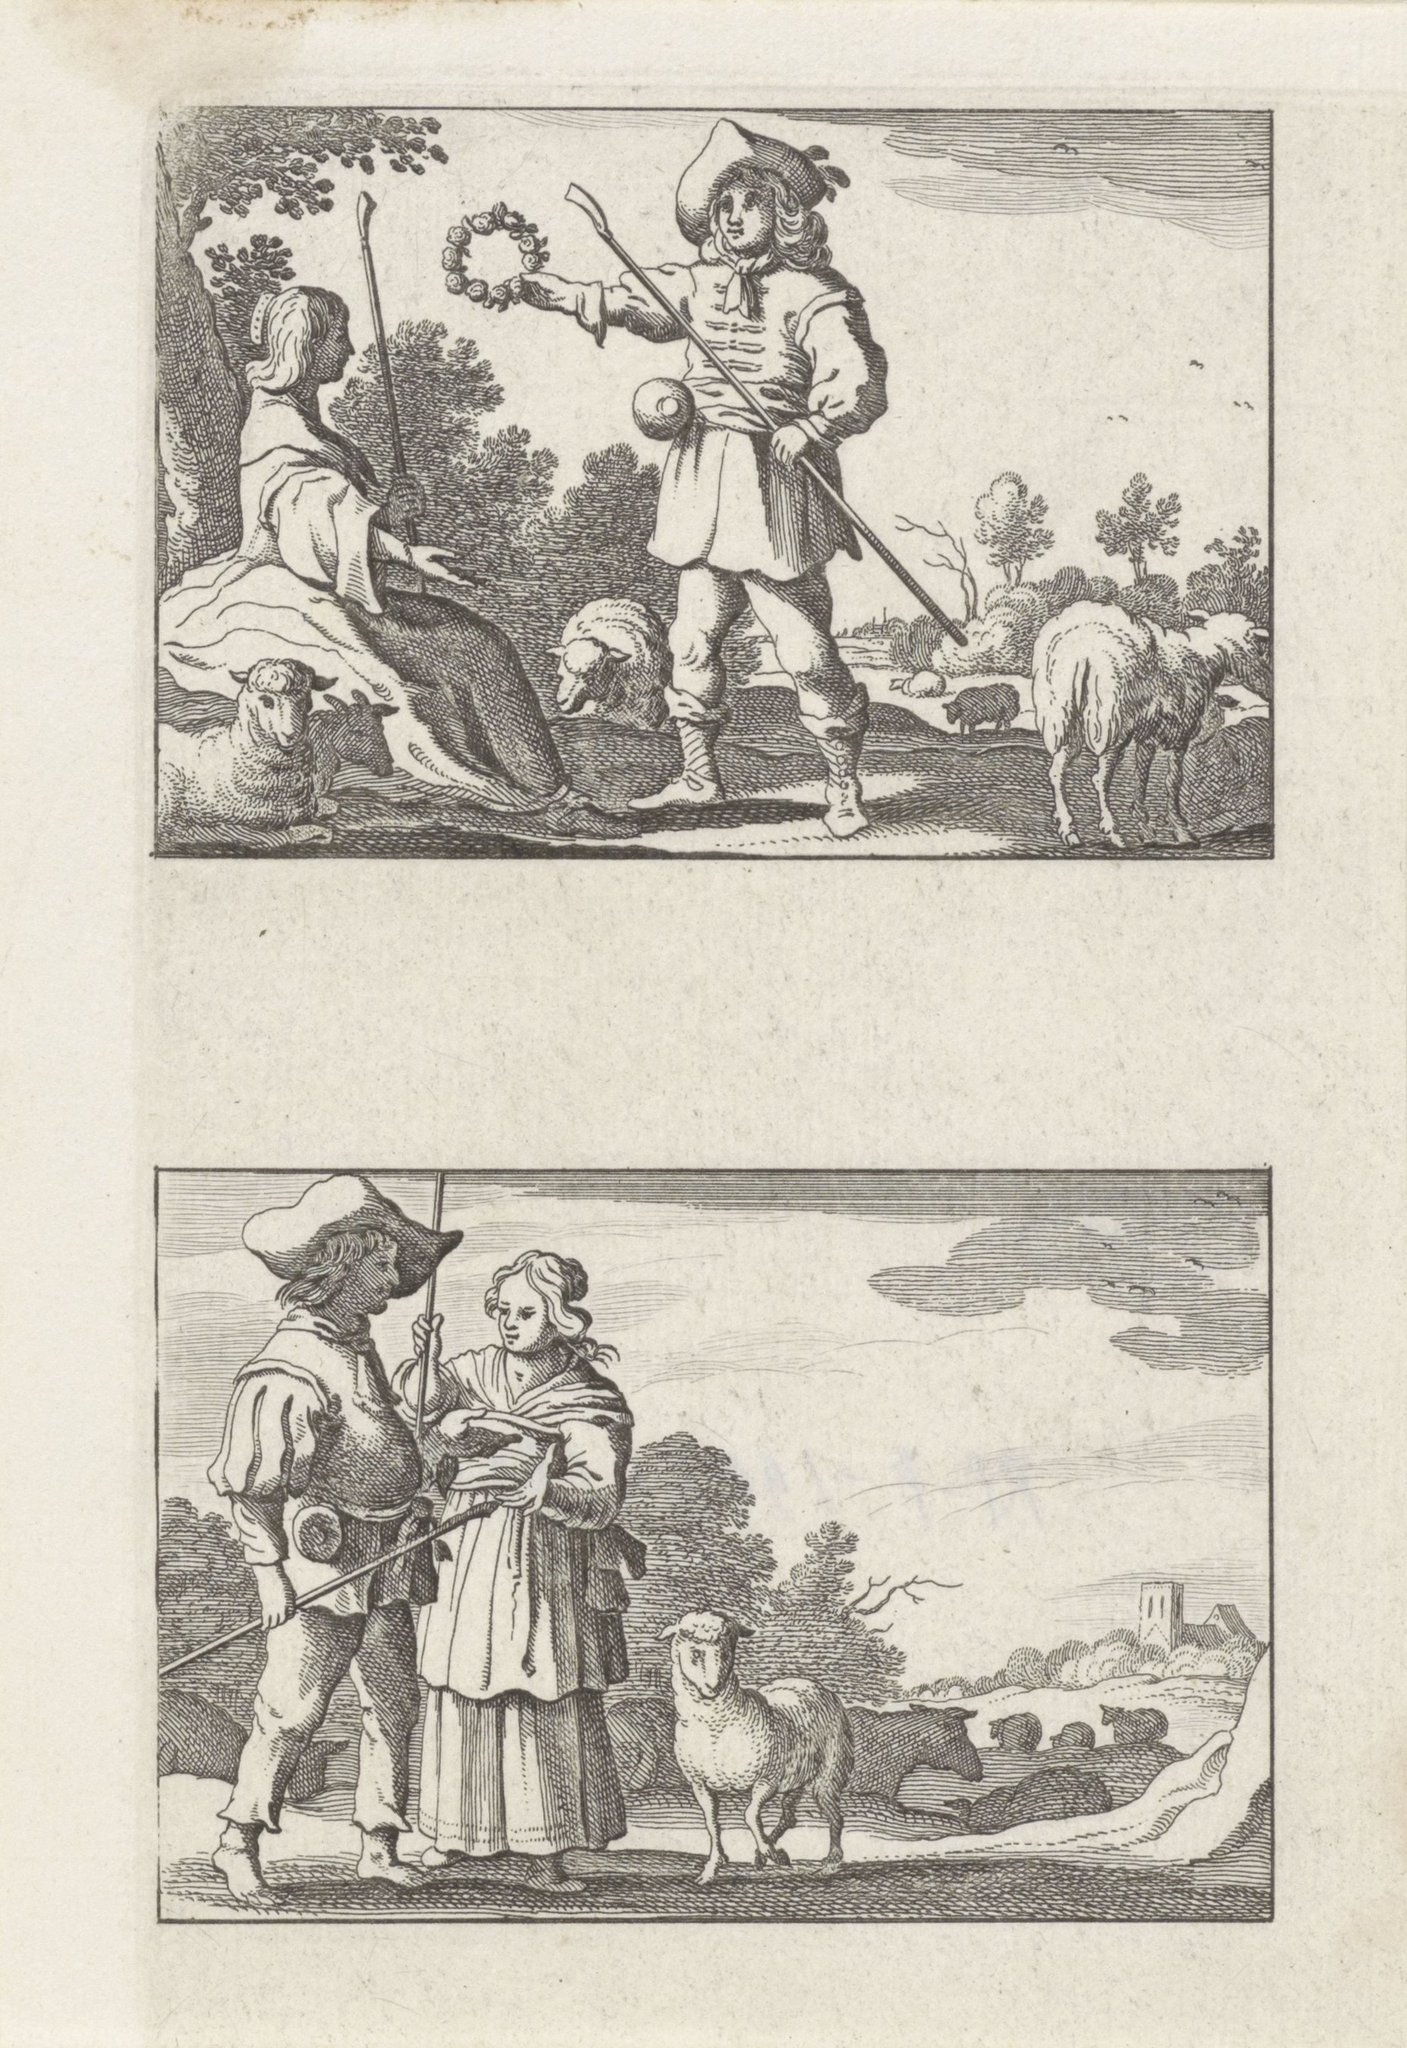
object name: popular print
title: Herders en herderinnen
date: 1633-1679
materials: paper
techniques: etching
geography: netherlands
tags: pastorals, arcadian scenes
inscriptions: collector's mark: Lugt 2228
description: Blad met 2 voorstellingen van herders en herderinnen in een landschap. Boven een herder die een bloemenkrans aanbiedt aan een herderin. Onder een herder en herderin in gesprek.